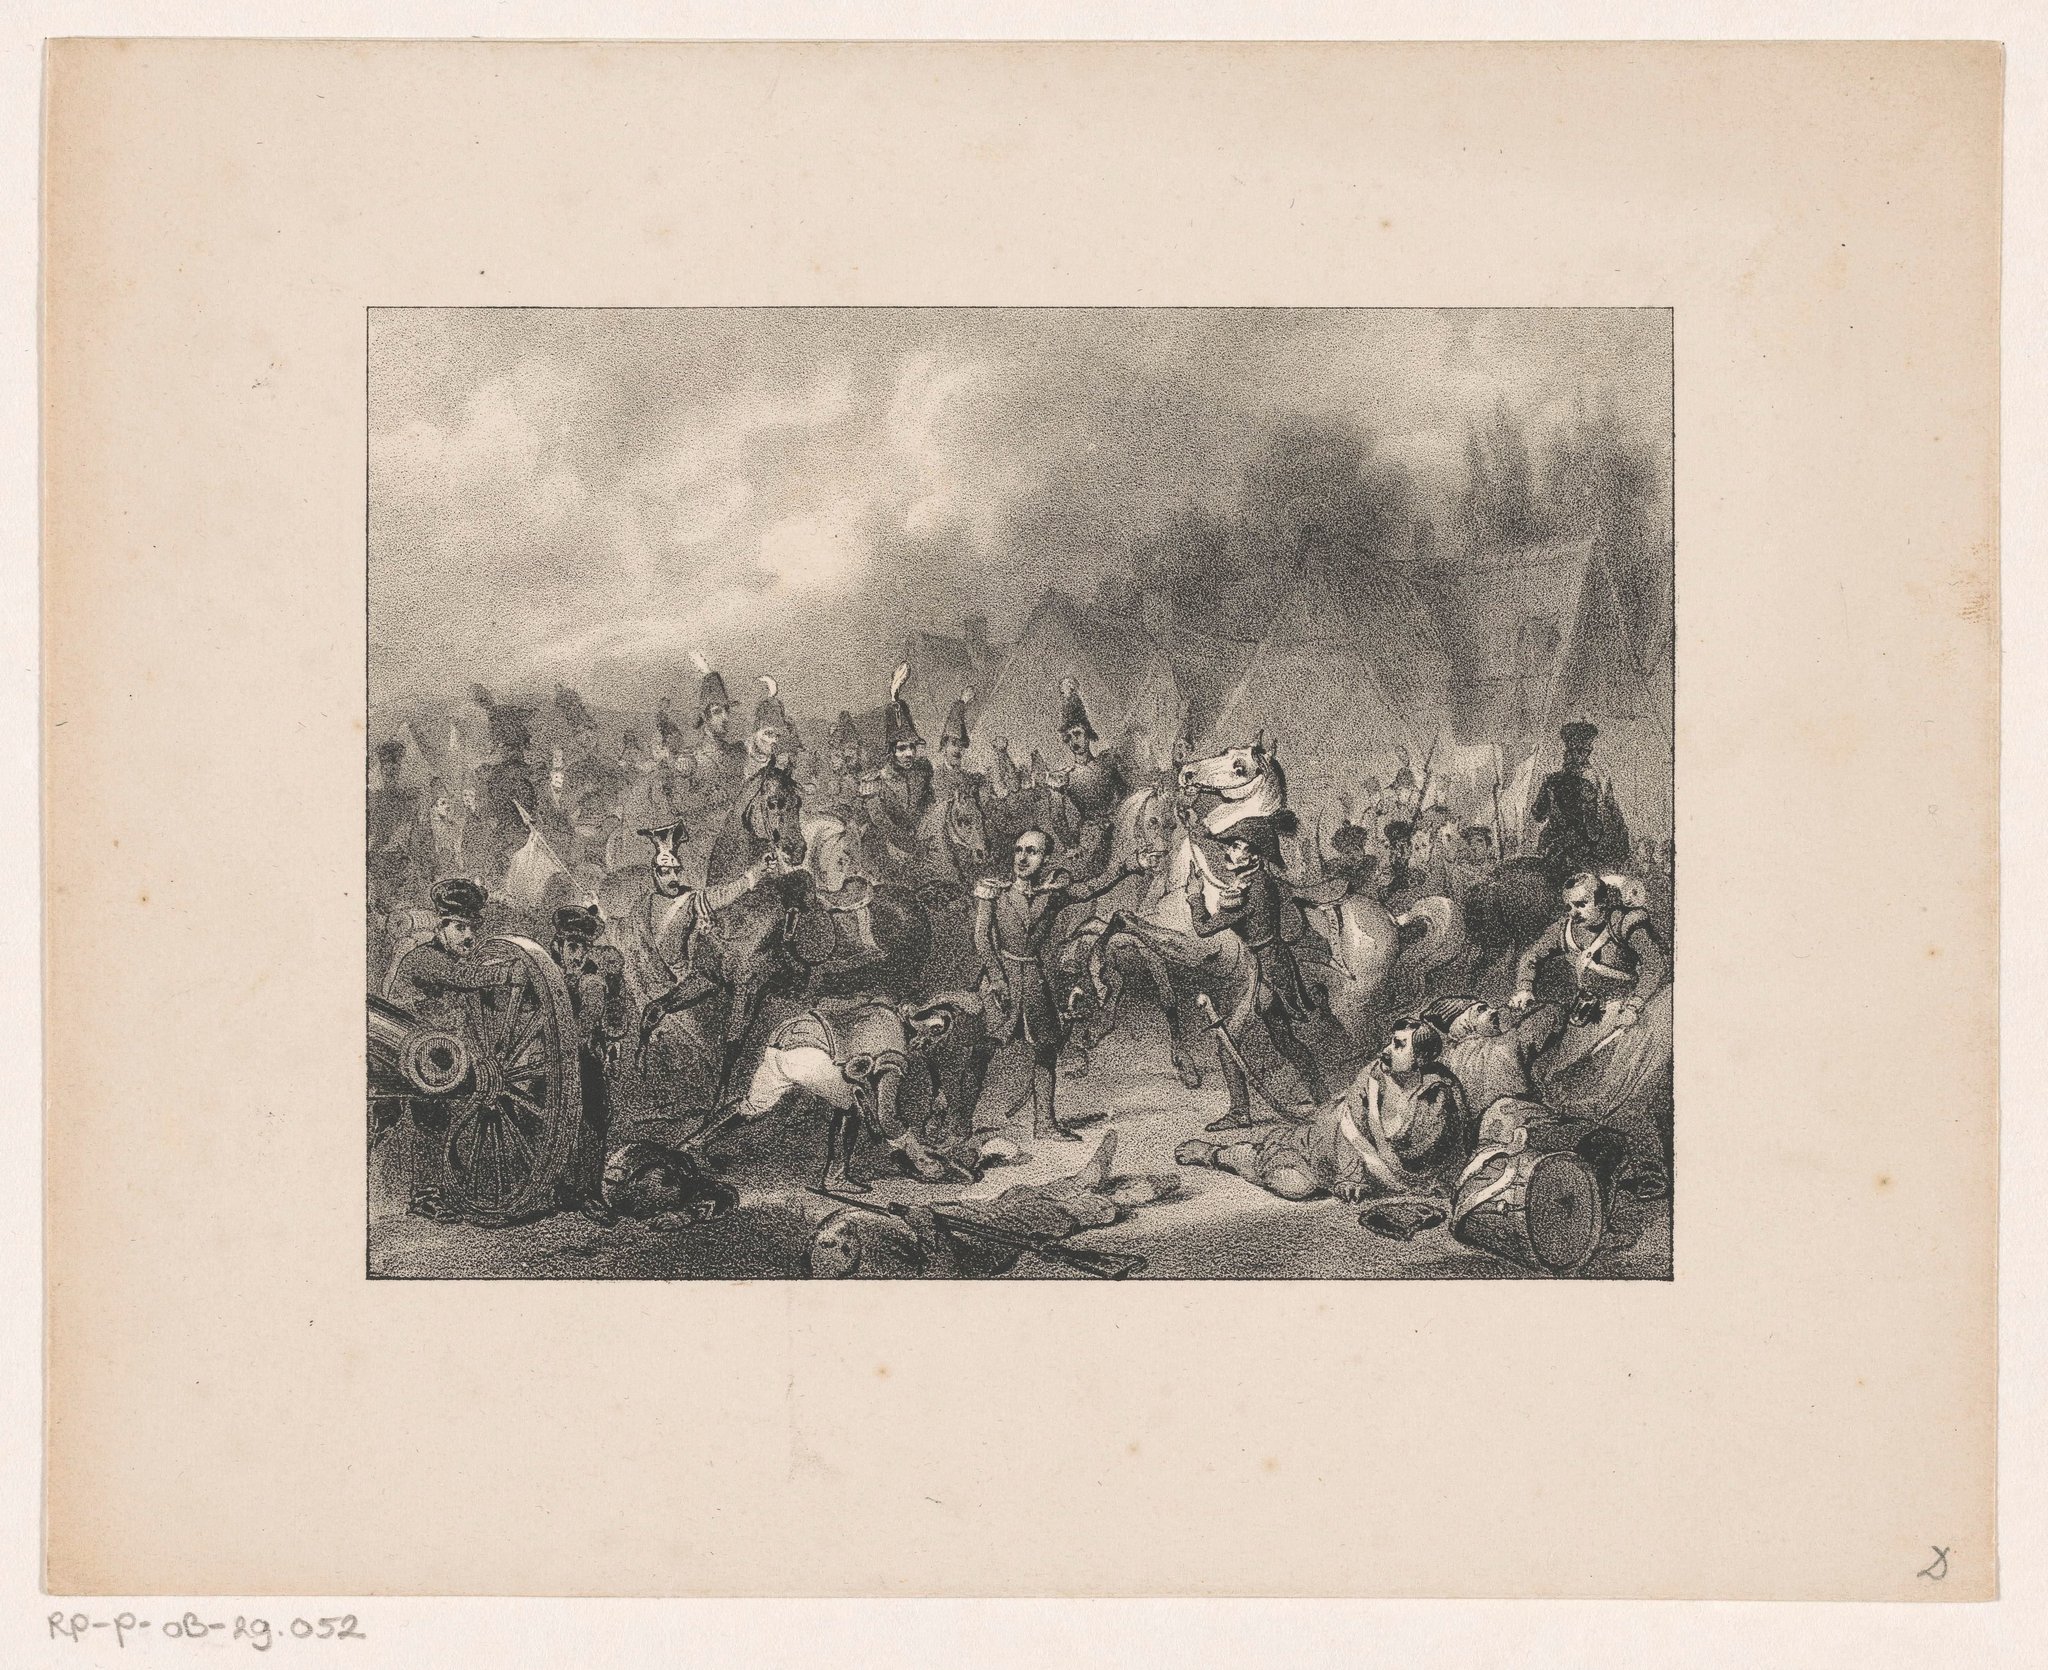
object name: print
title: Veldslag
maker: carel christiaan antony last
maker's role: print maker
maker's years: 1808-1876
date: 1818-1876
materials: paper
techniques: lithograph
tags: firearms: cannon, charge ~ battle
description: In het midden van de troepen te paard staat een aanvoerder. Hij wijst vooruit. In de voorgrond een kanon en gewonden.